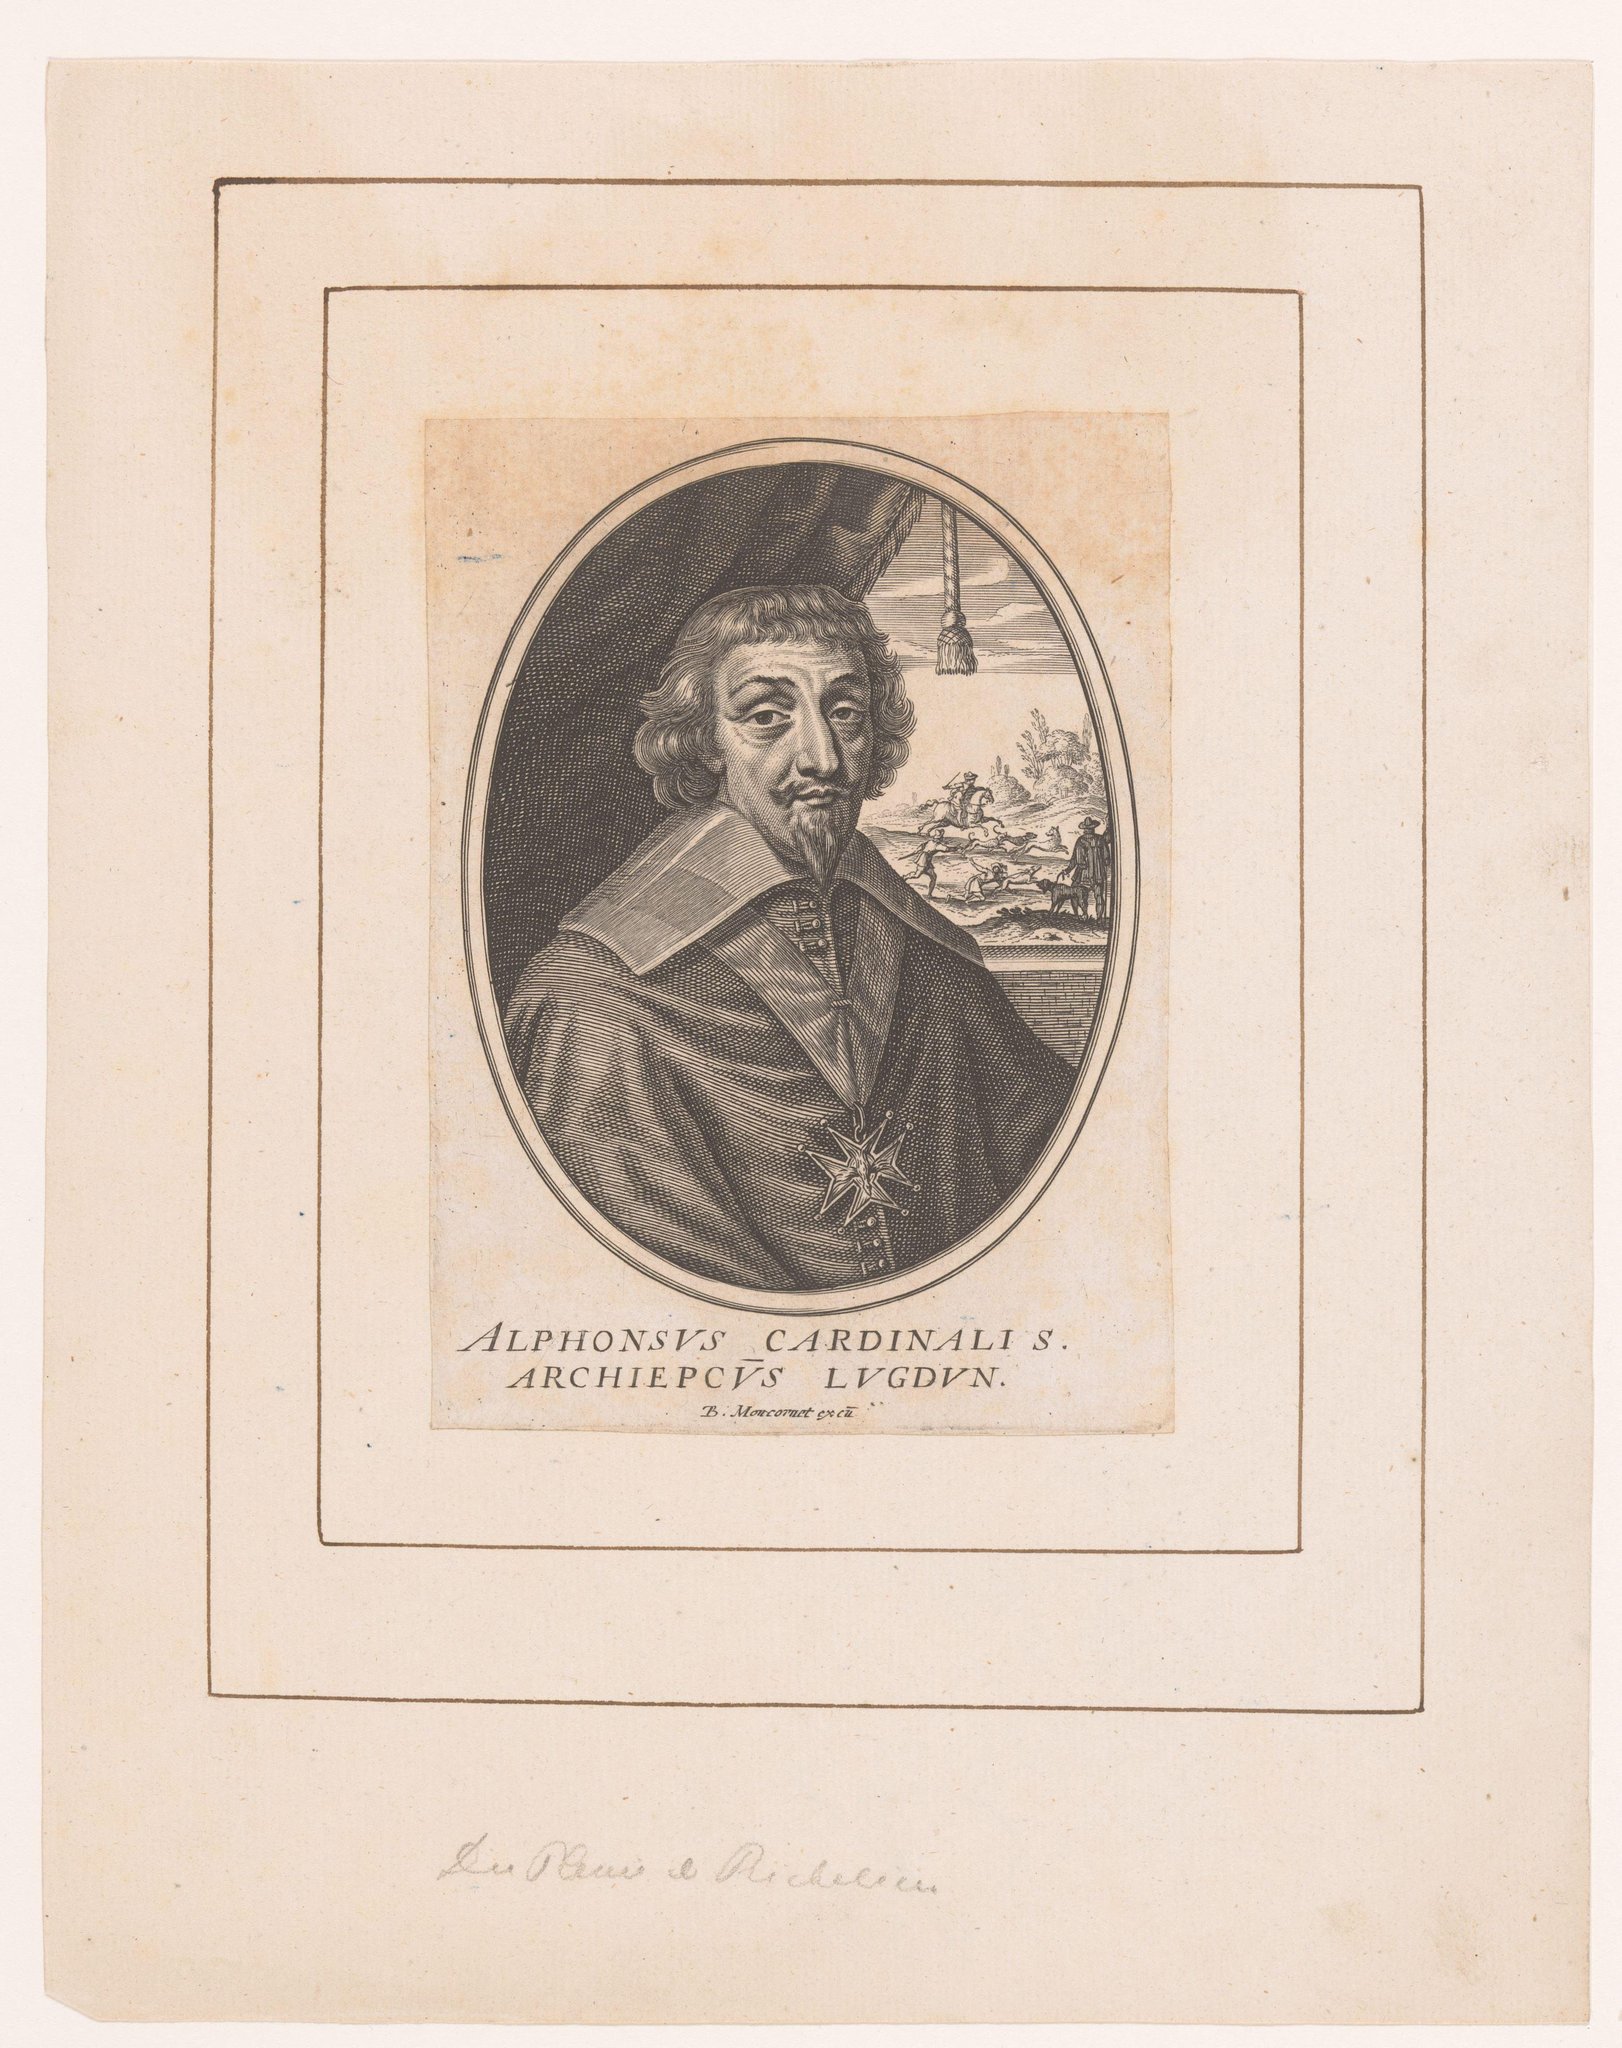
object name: print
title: Portret van Alphonse-Louis du Plessis de Richelieu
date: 1610-1668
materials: paper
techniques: engraving, etching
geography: paris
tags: alphonse-louis du plessis de richelieu, historical persons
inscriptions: collector's mark: Lugt 2228